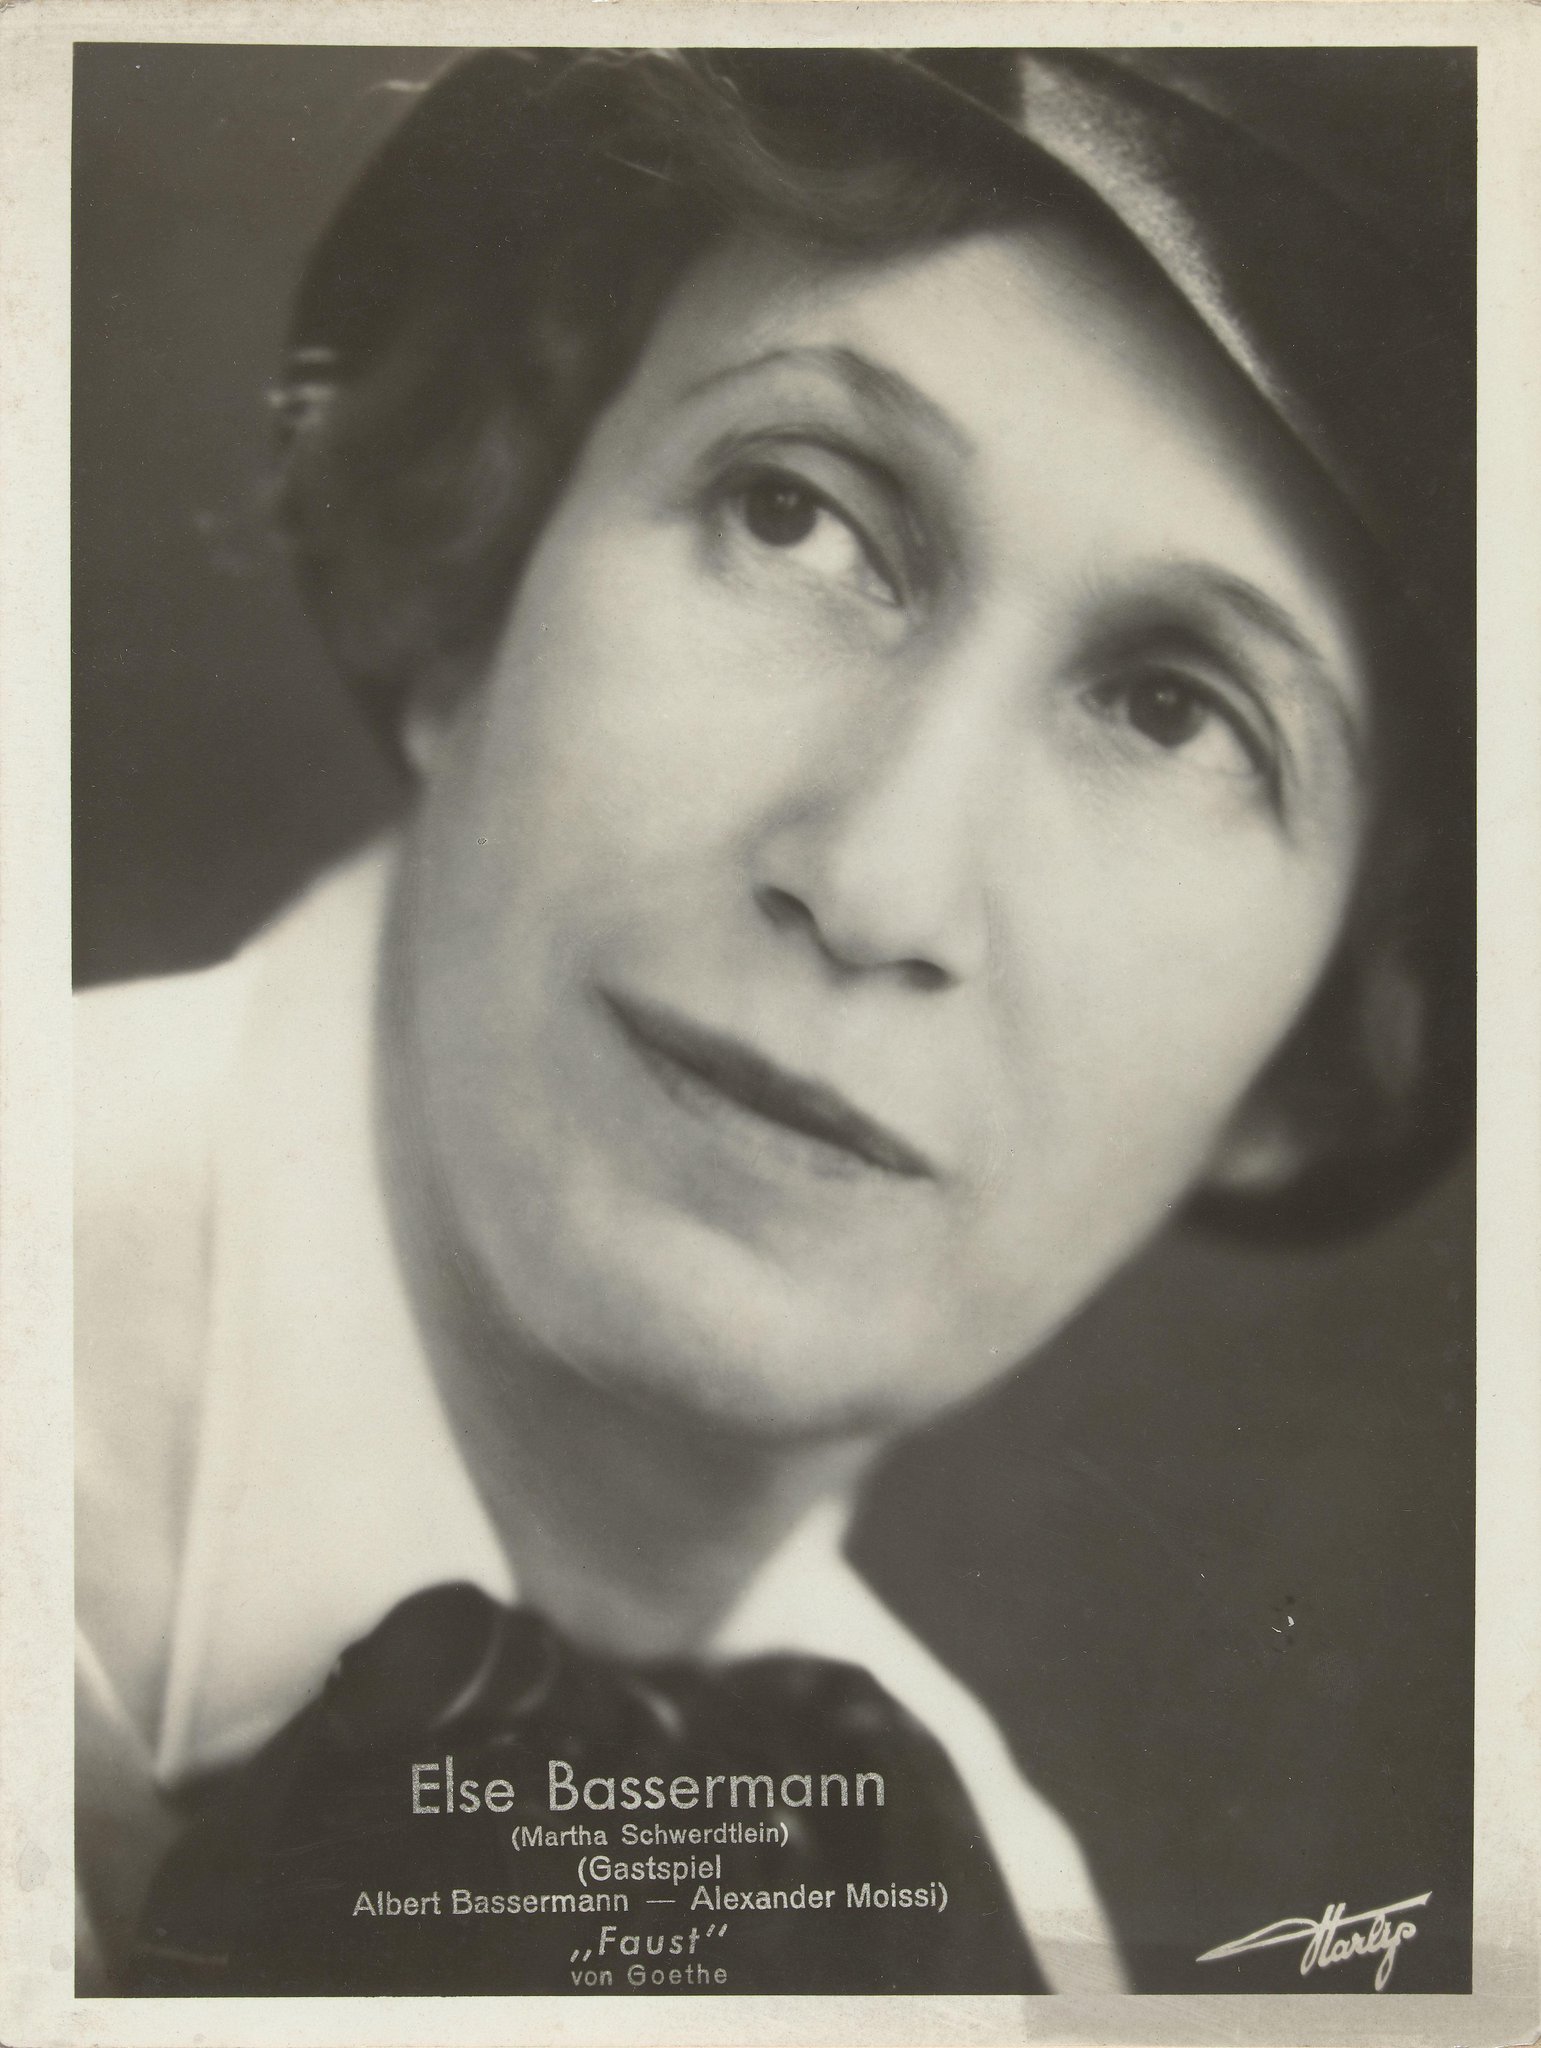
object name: photograph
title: Else Bassermann (Martha Schwerdtlein) Gastspiel Albert Baassermann - Alexander Moissi "Faust"von Goethe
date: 1920-1985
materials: photographic support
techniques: gelatin silver print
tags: leipzig, baden-baden, else bassermann